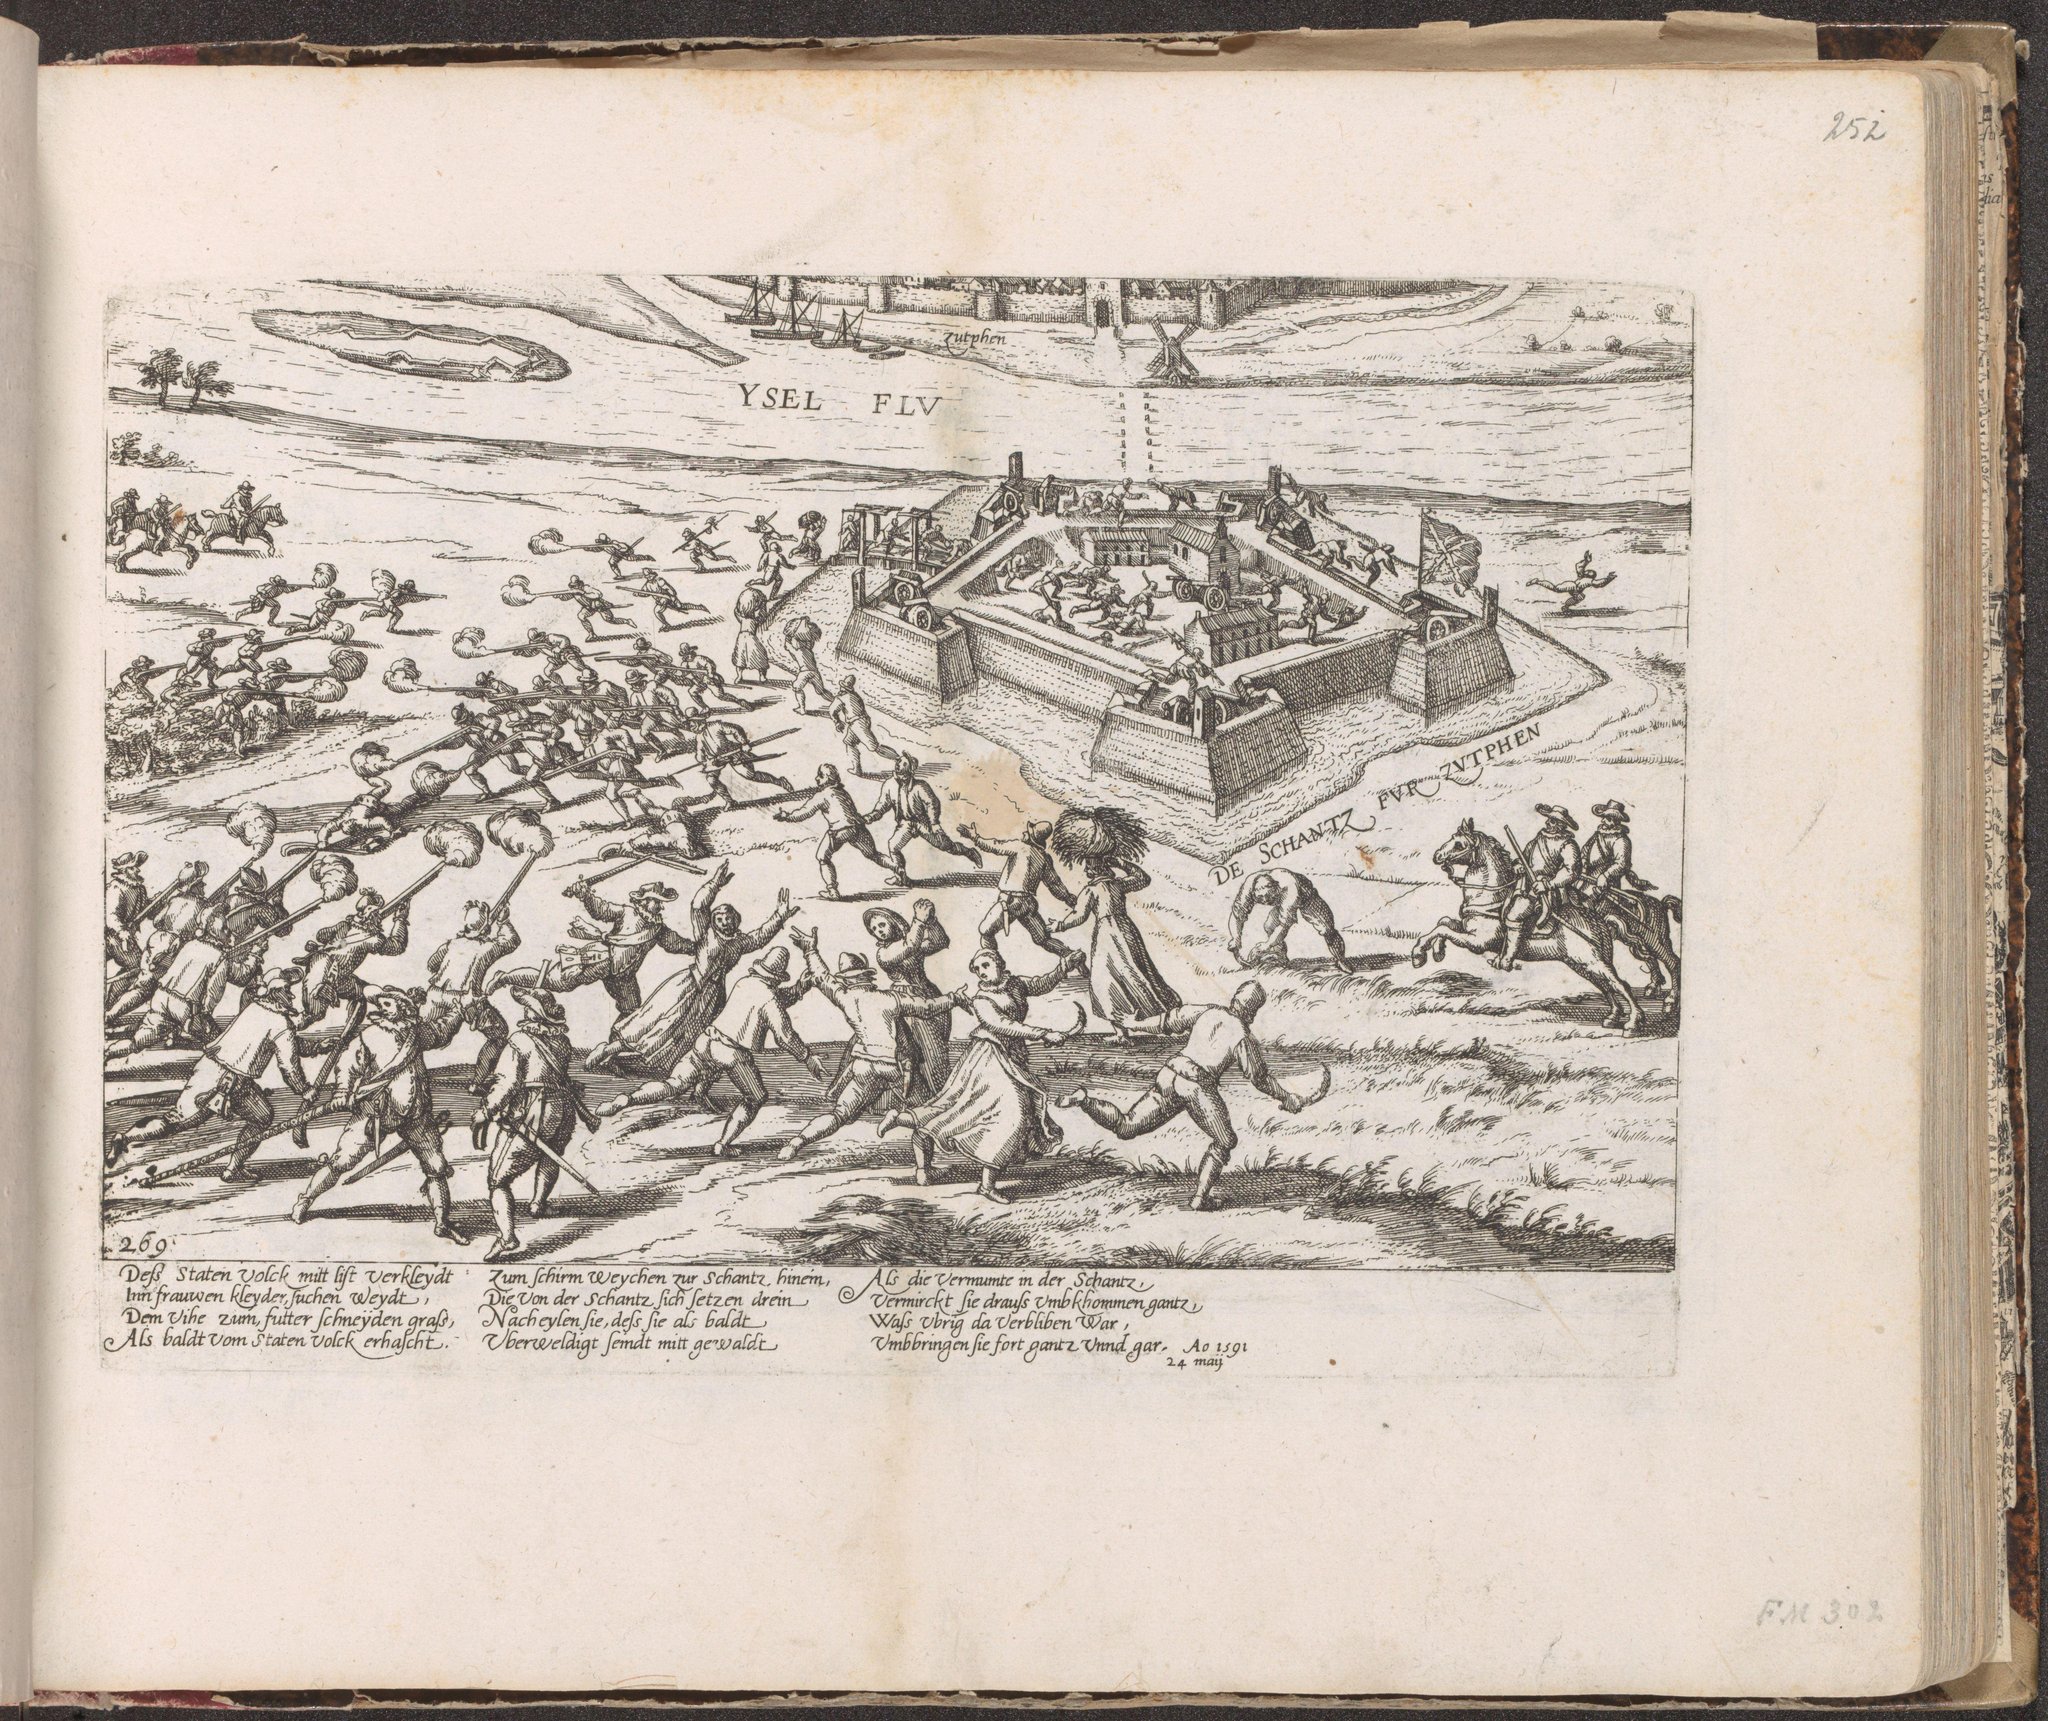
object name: album leaf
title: Serie 10: Nederlandse en Buitenlandse Gebeurtenissen, 1587-1612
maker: frans hogenberg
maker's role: print maker, publisher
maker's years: 1538-1590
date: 1591-1593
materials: paper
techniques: etching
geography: cologne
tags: capture of city (after the siege)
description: Inname van de schans bij Zutphen, 24 mei 1591. Verovering van de schans door middel van een list waarbij Staatse soldaten verkleed waren als boerinnen. Met onderschrift van 12 regels in het Duits. Linksonder genummerd: 269. De prent maakt deel uit van een album.